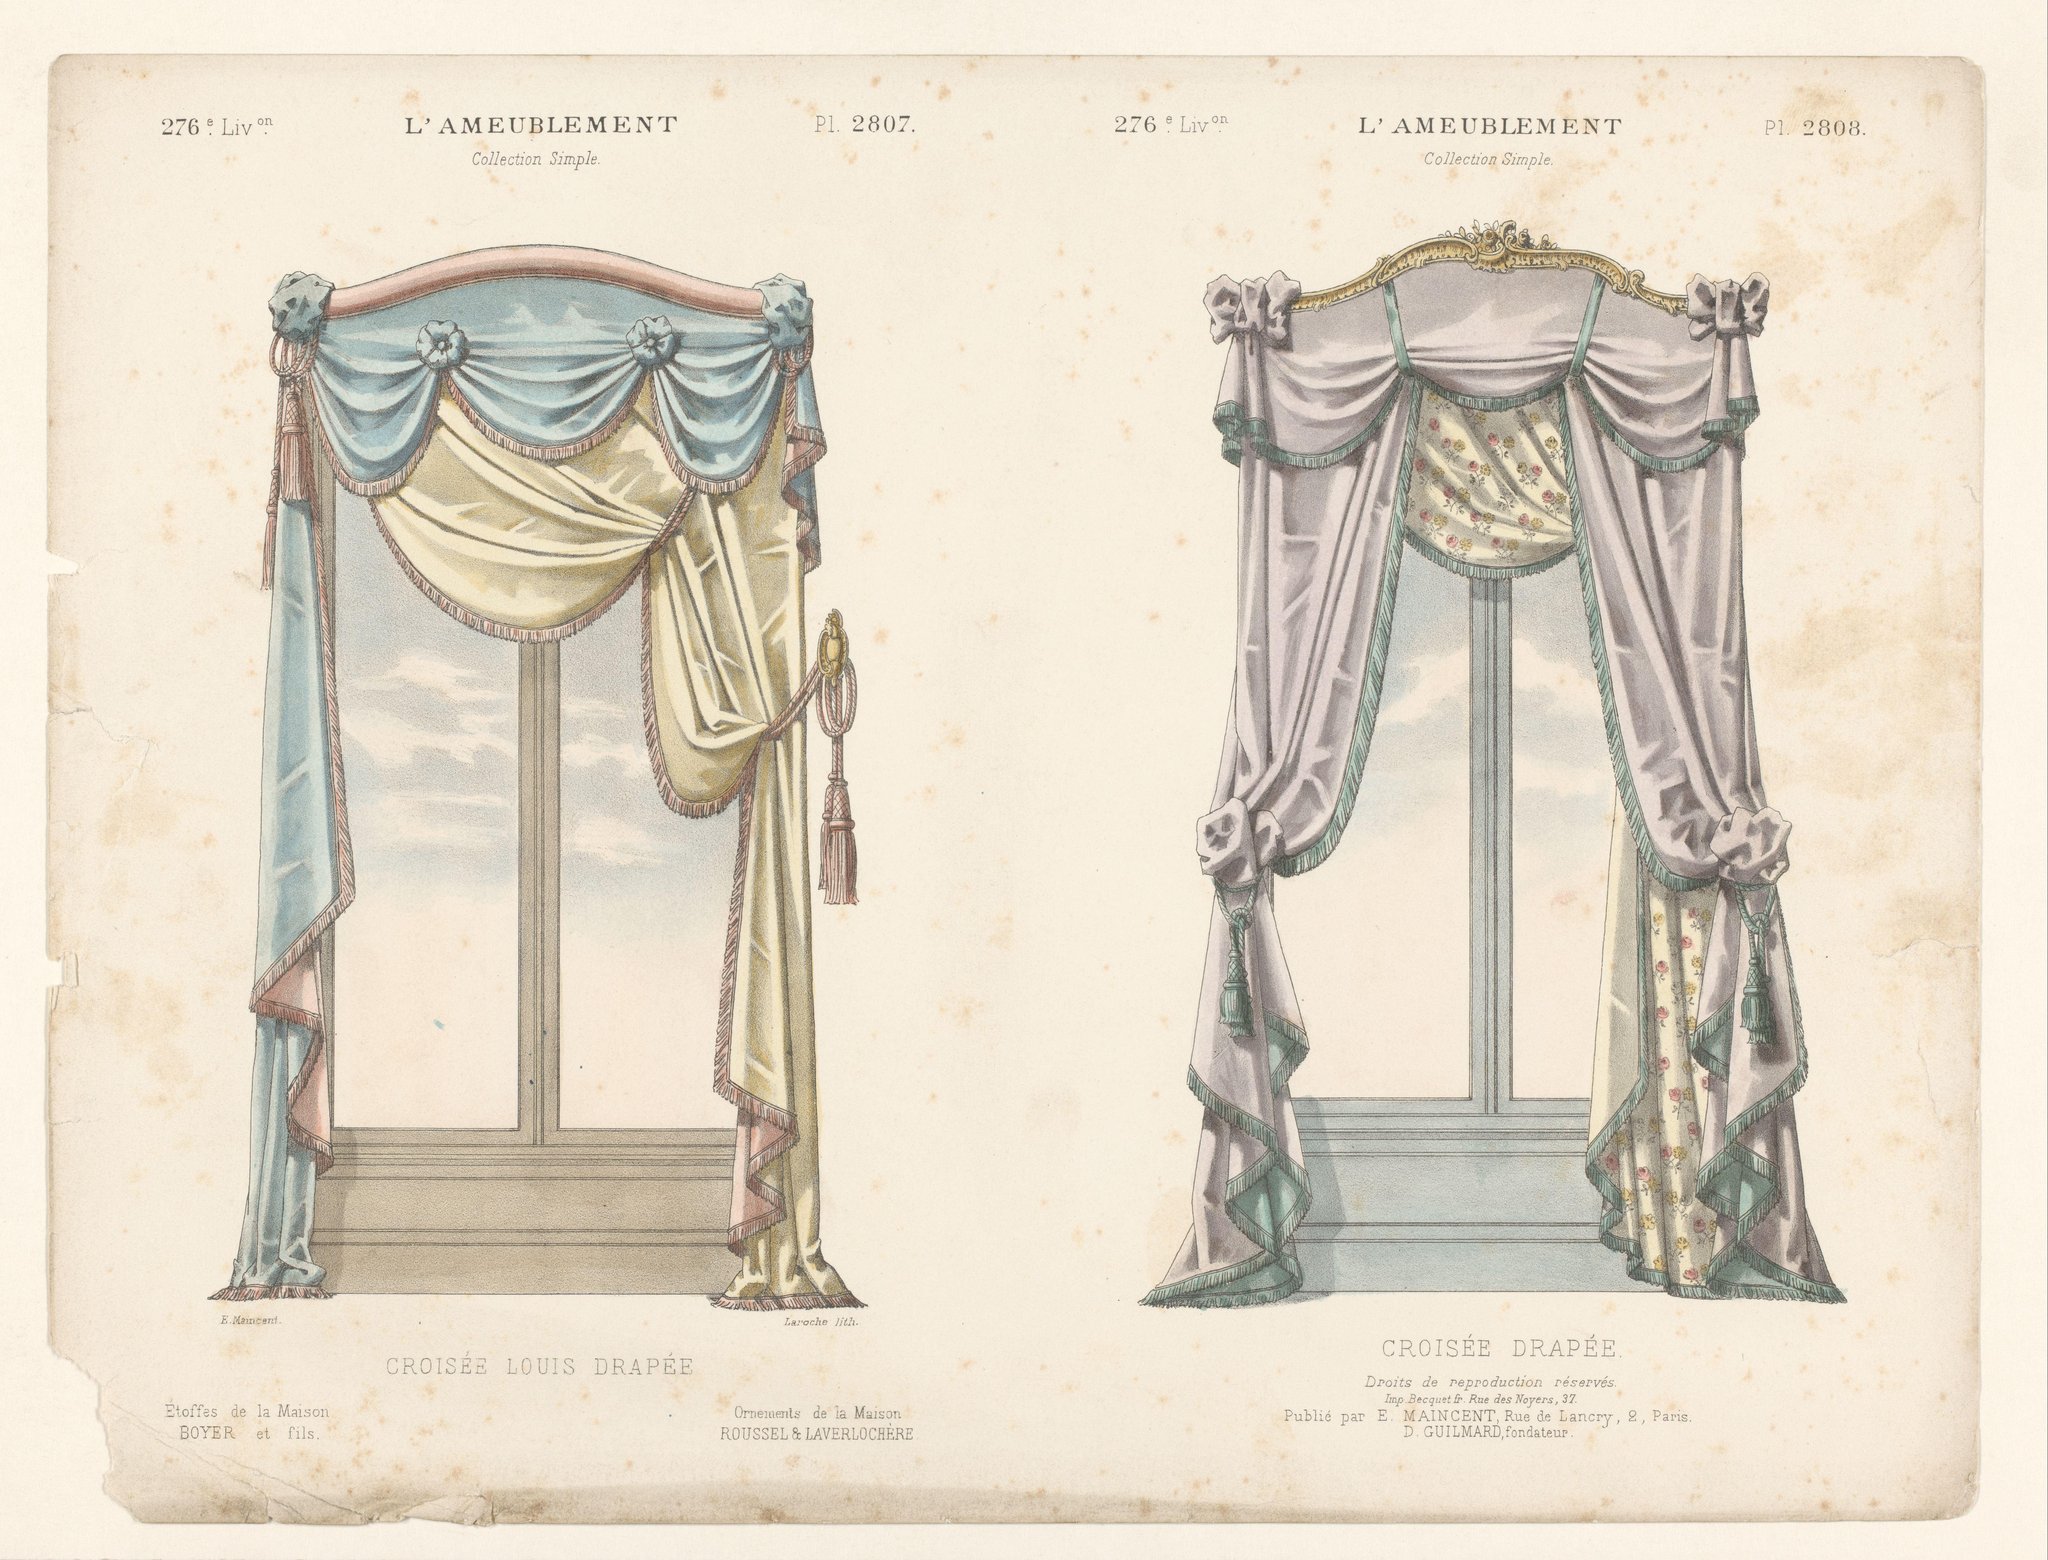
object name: print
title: Croisée Louis drapée / Croisée drapée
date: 1885-1895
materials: paper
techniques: hand coloring, lithograph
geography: paris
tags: window, hangings and drapery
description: Twee vensters met gedrapeerde gordijnen. Prent uit 276e Livraison.